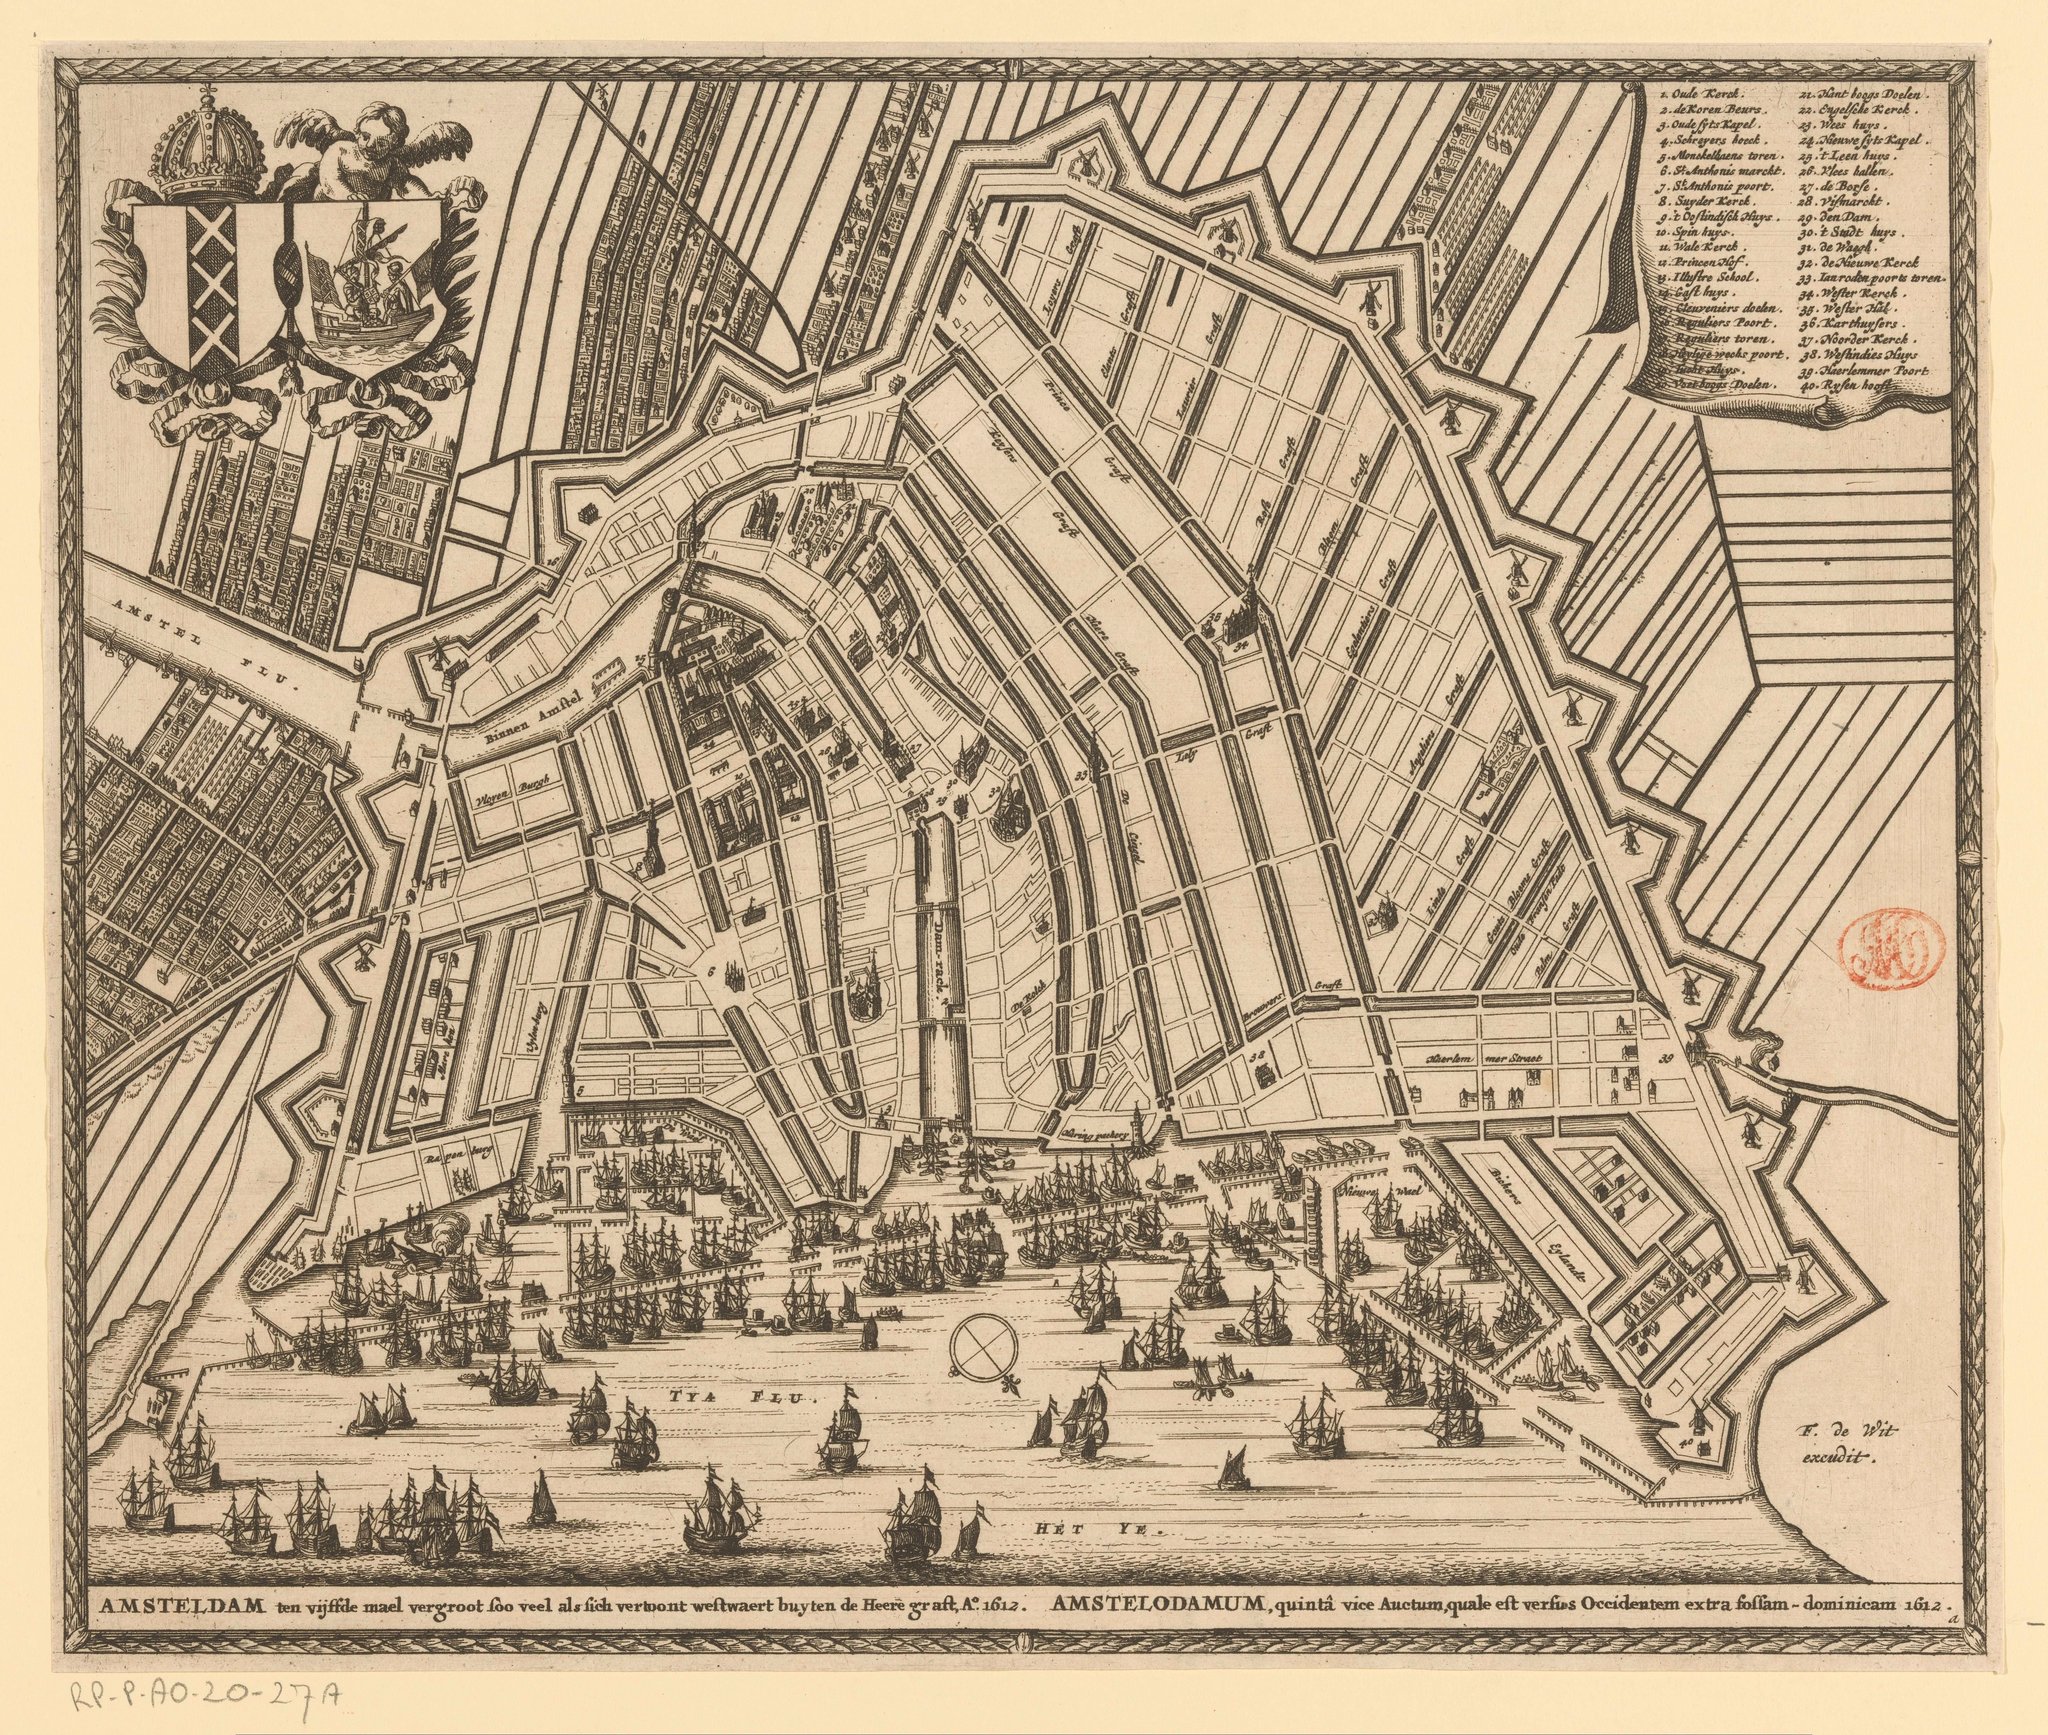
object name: area plan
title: Vier historische kaarten van Amsterdam (De Wit I)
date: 1671-1680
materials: paper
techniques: engraving, etching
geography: amsterdam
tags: coat of arms (as symbol of the state, etc.) (+ city; municipal), seal (as symbol of the state, etc.) (+ city; municipal), maps of cities, amsterdam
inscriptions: collector's mark: Lugt 195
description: Plattegrond van Amsterdam zoals het er na de uitbreiding in 1612 uit zou hebben gezien. Met gebouwen in vogelvluchtperspectief. Linksboven het wapen en zegel van de stad. Rechtsboven een cartouche met de legenda 1-40. Rechtsonder gemerkt: a. Oriëntatie: zuidzuidwest boven.